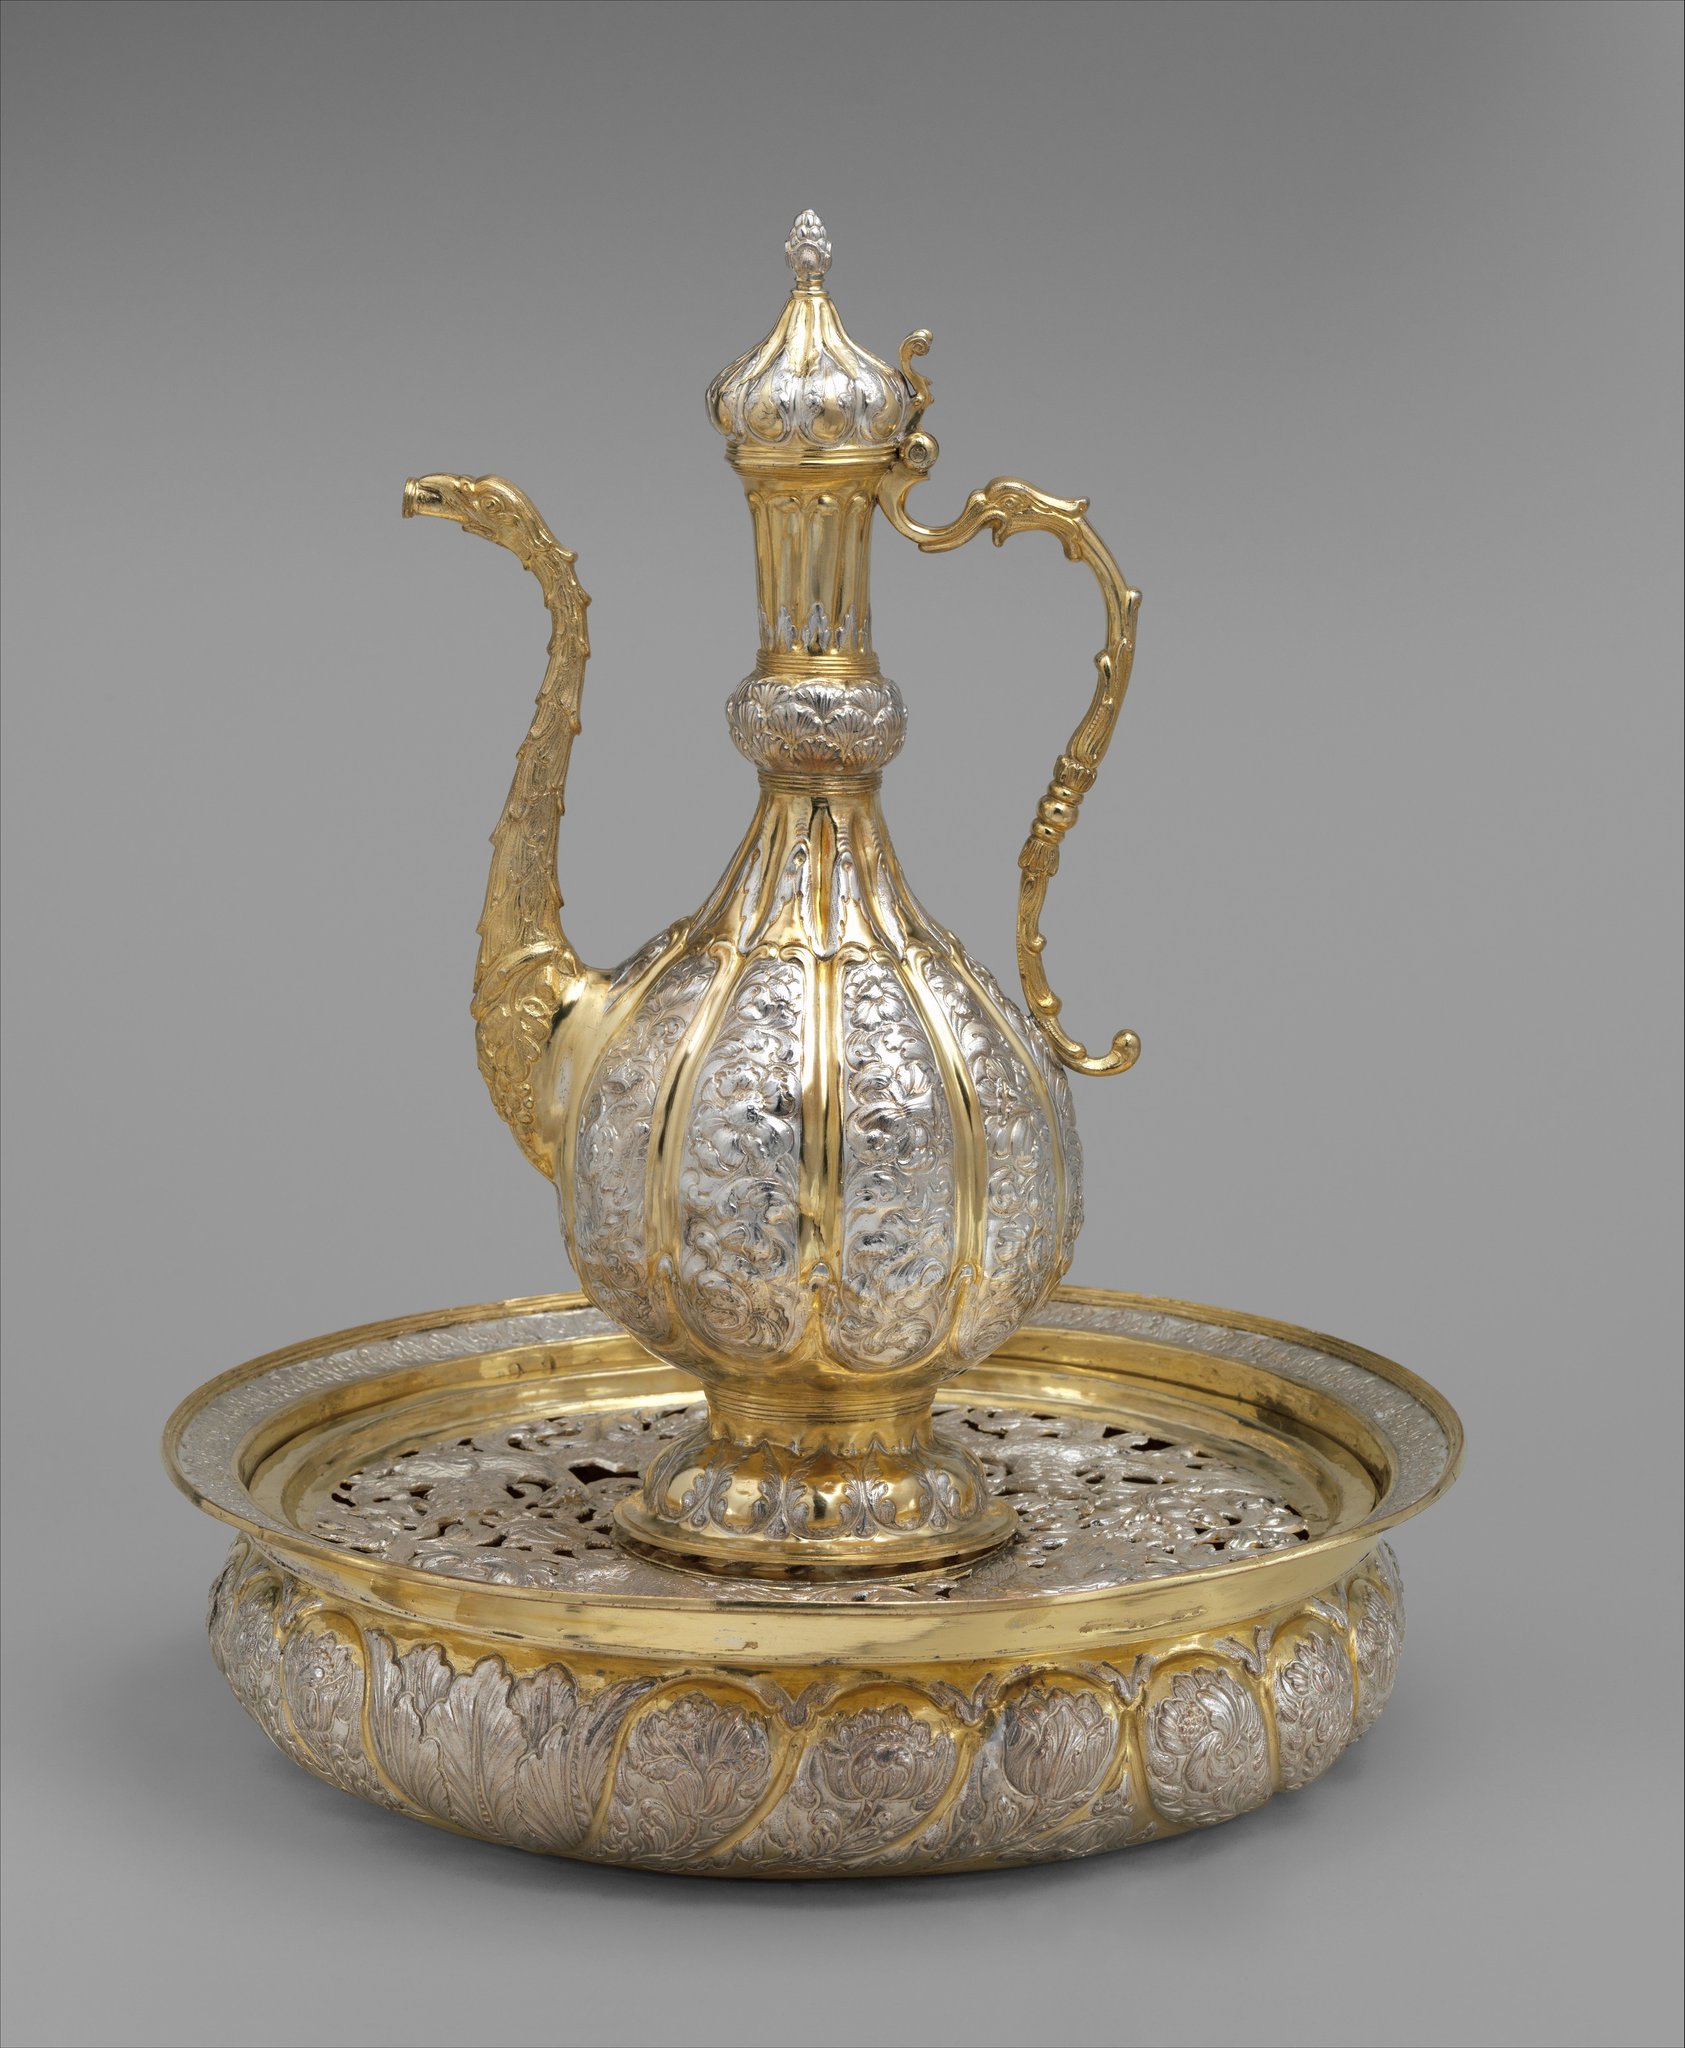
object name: ewer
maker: elkington & co.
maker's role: manufacturer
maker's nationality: british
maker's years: 1829-1963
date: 1801-1900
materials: gilt, metal, silver